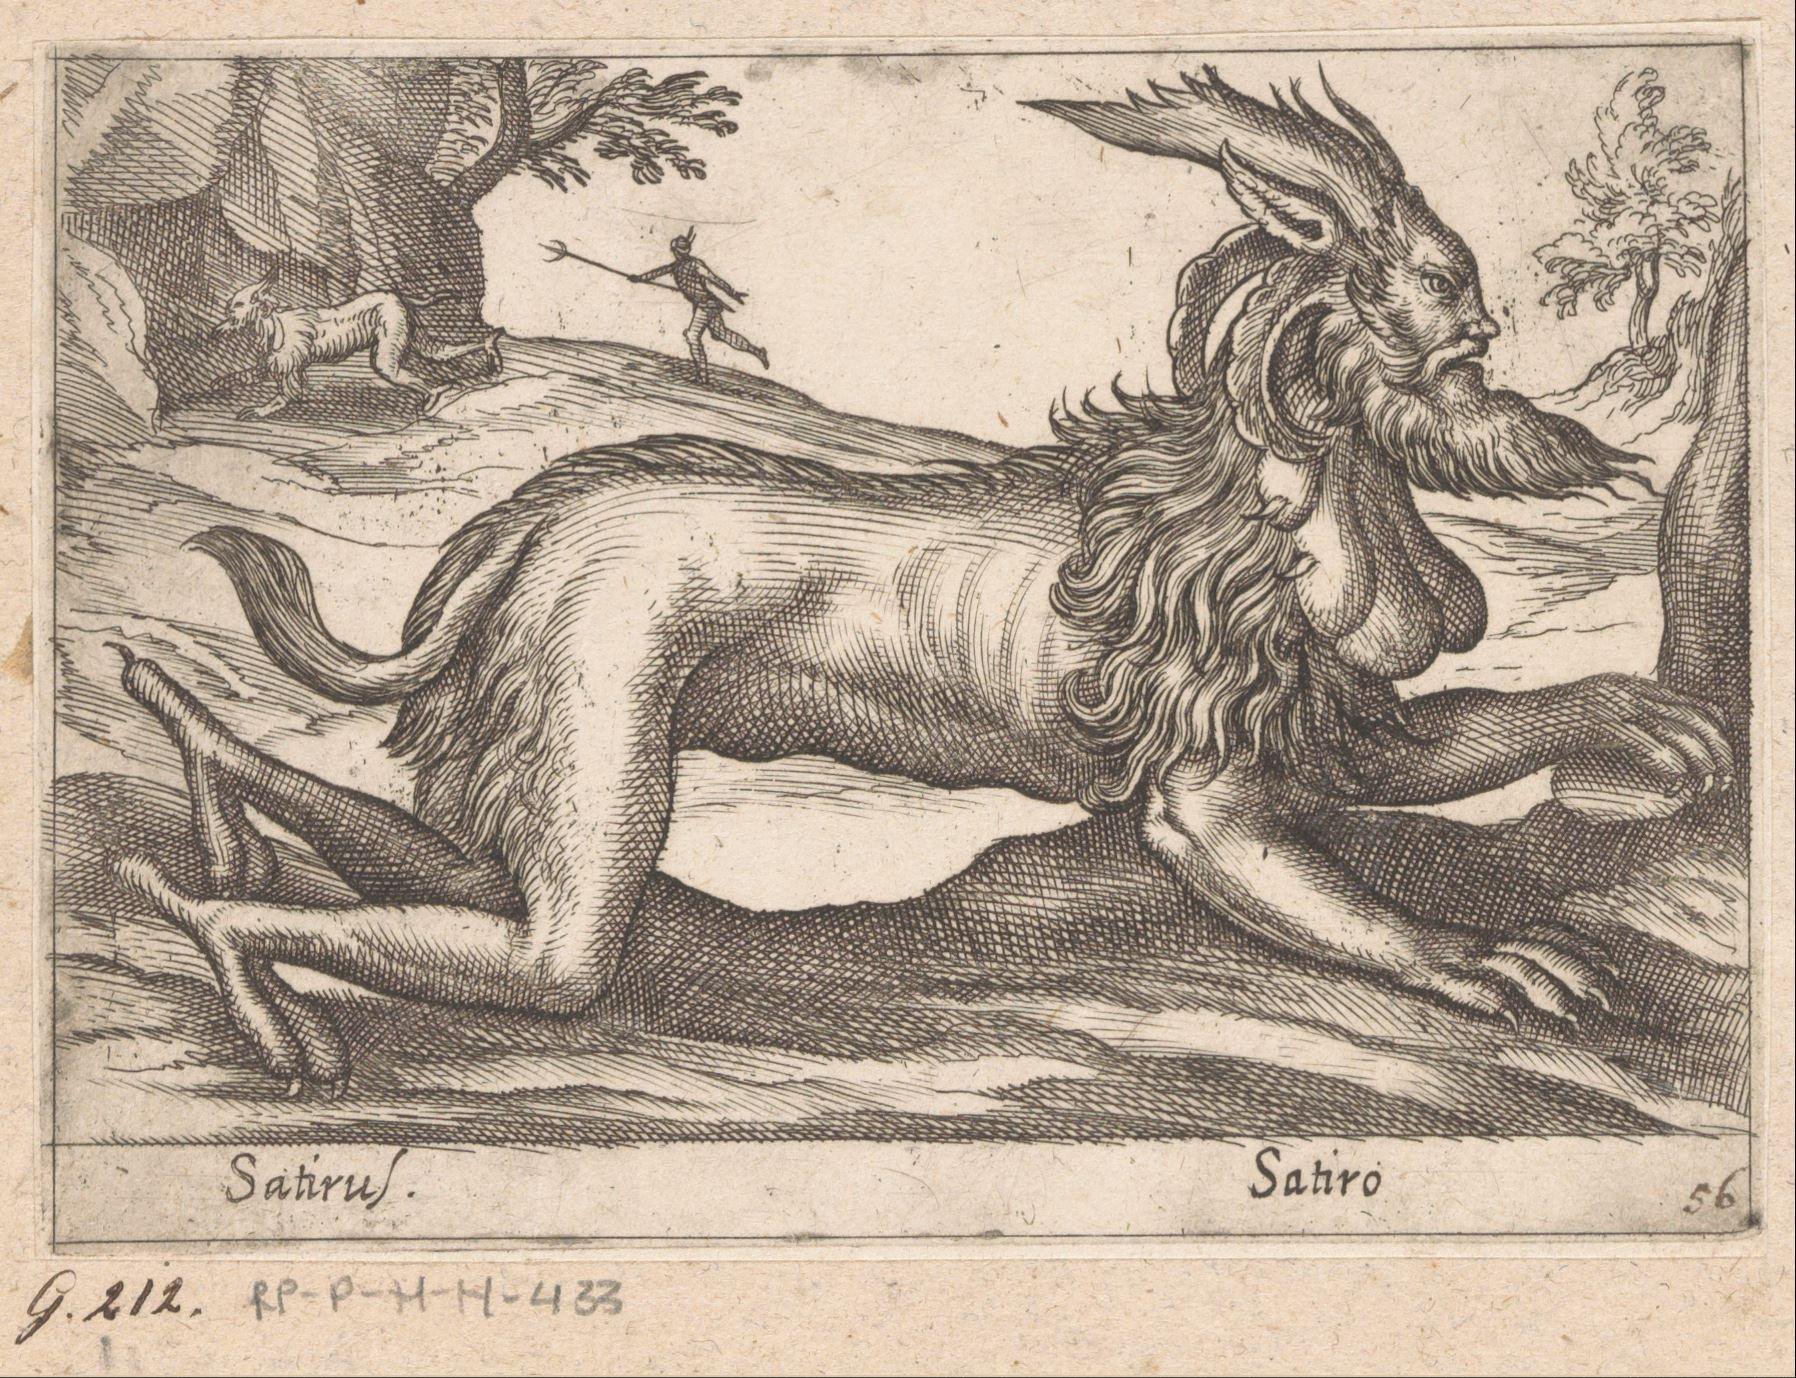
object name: print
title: Monsterlijk wezen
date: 1565-1630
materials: paper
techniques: etching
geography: italy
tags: mis-shapen animals; monsters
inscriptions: number: ‘56’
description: Deze prent maakt deel uit van een reeks prenten van dieren door Antonio Tempesta. Bekend is dat een tweede staat (met nummering) van deze serie is uitgegeven door Giovanni Giacomo de' Rossi in 1650. Onbekend is wie de eerste staat heeft uitgegeven en wanneer.